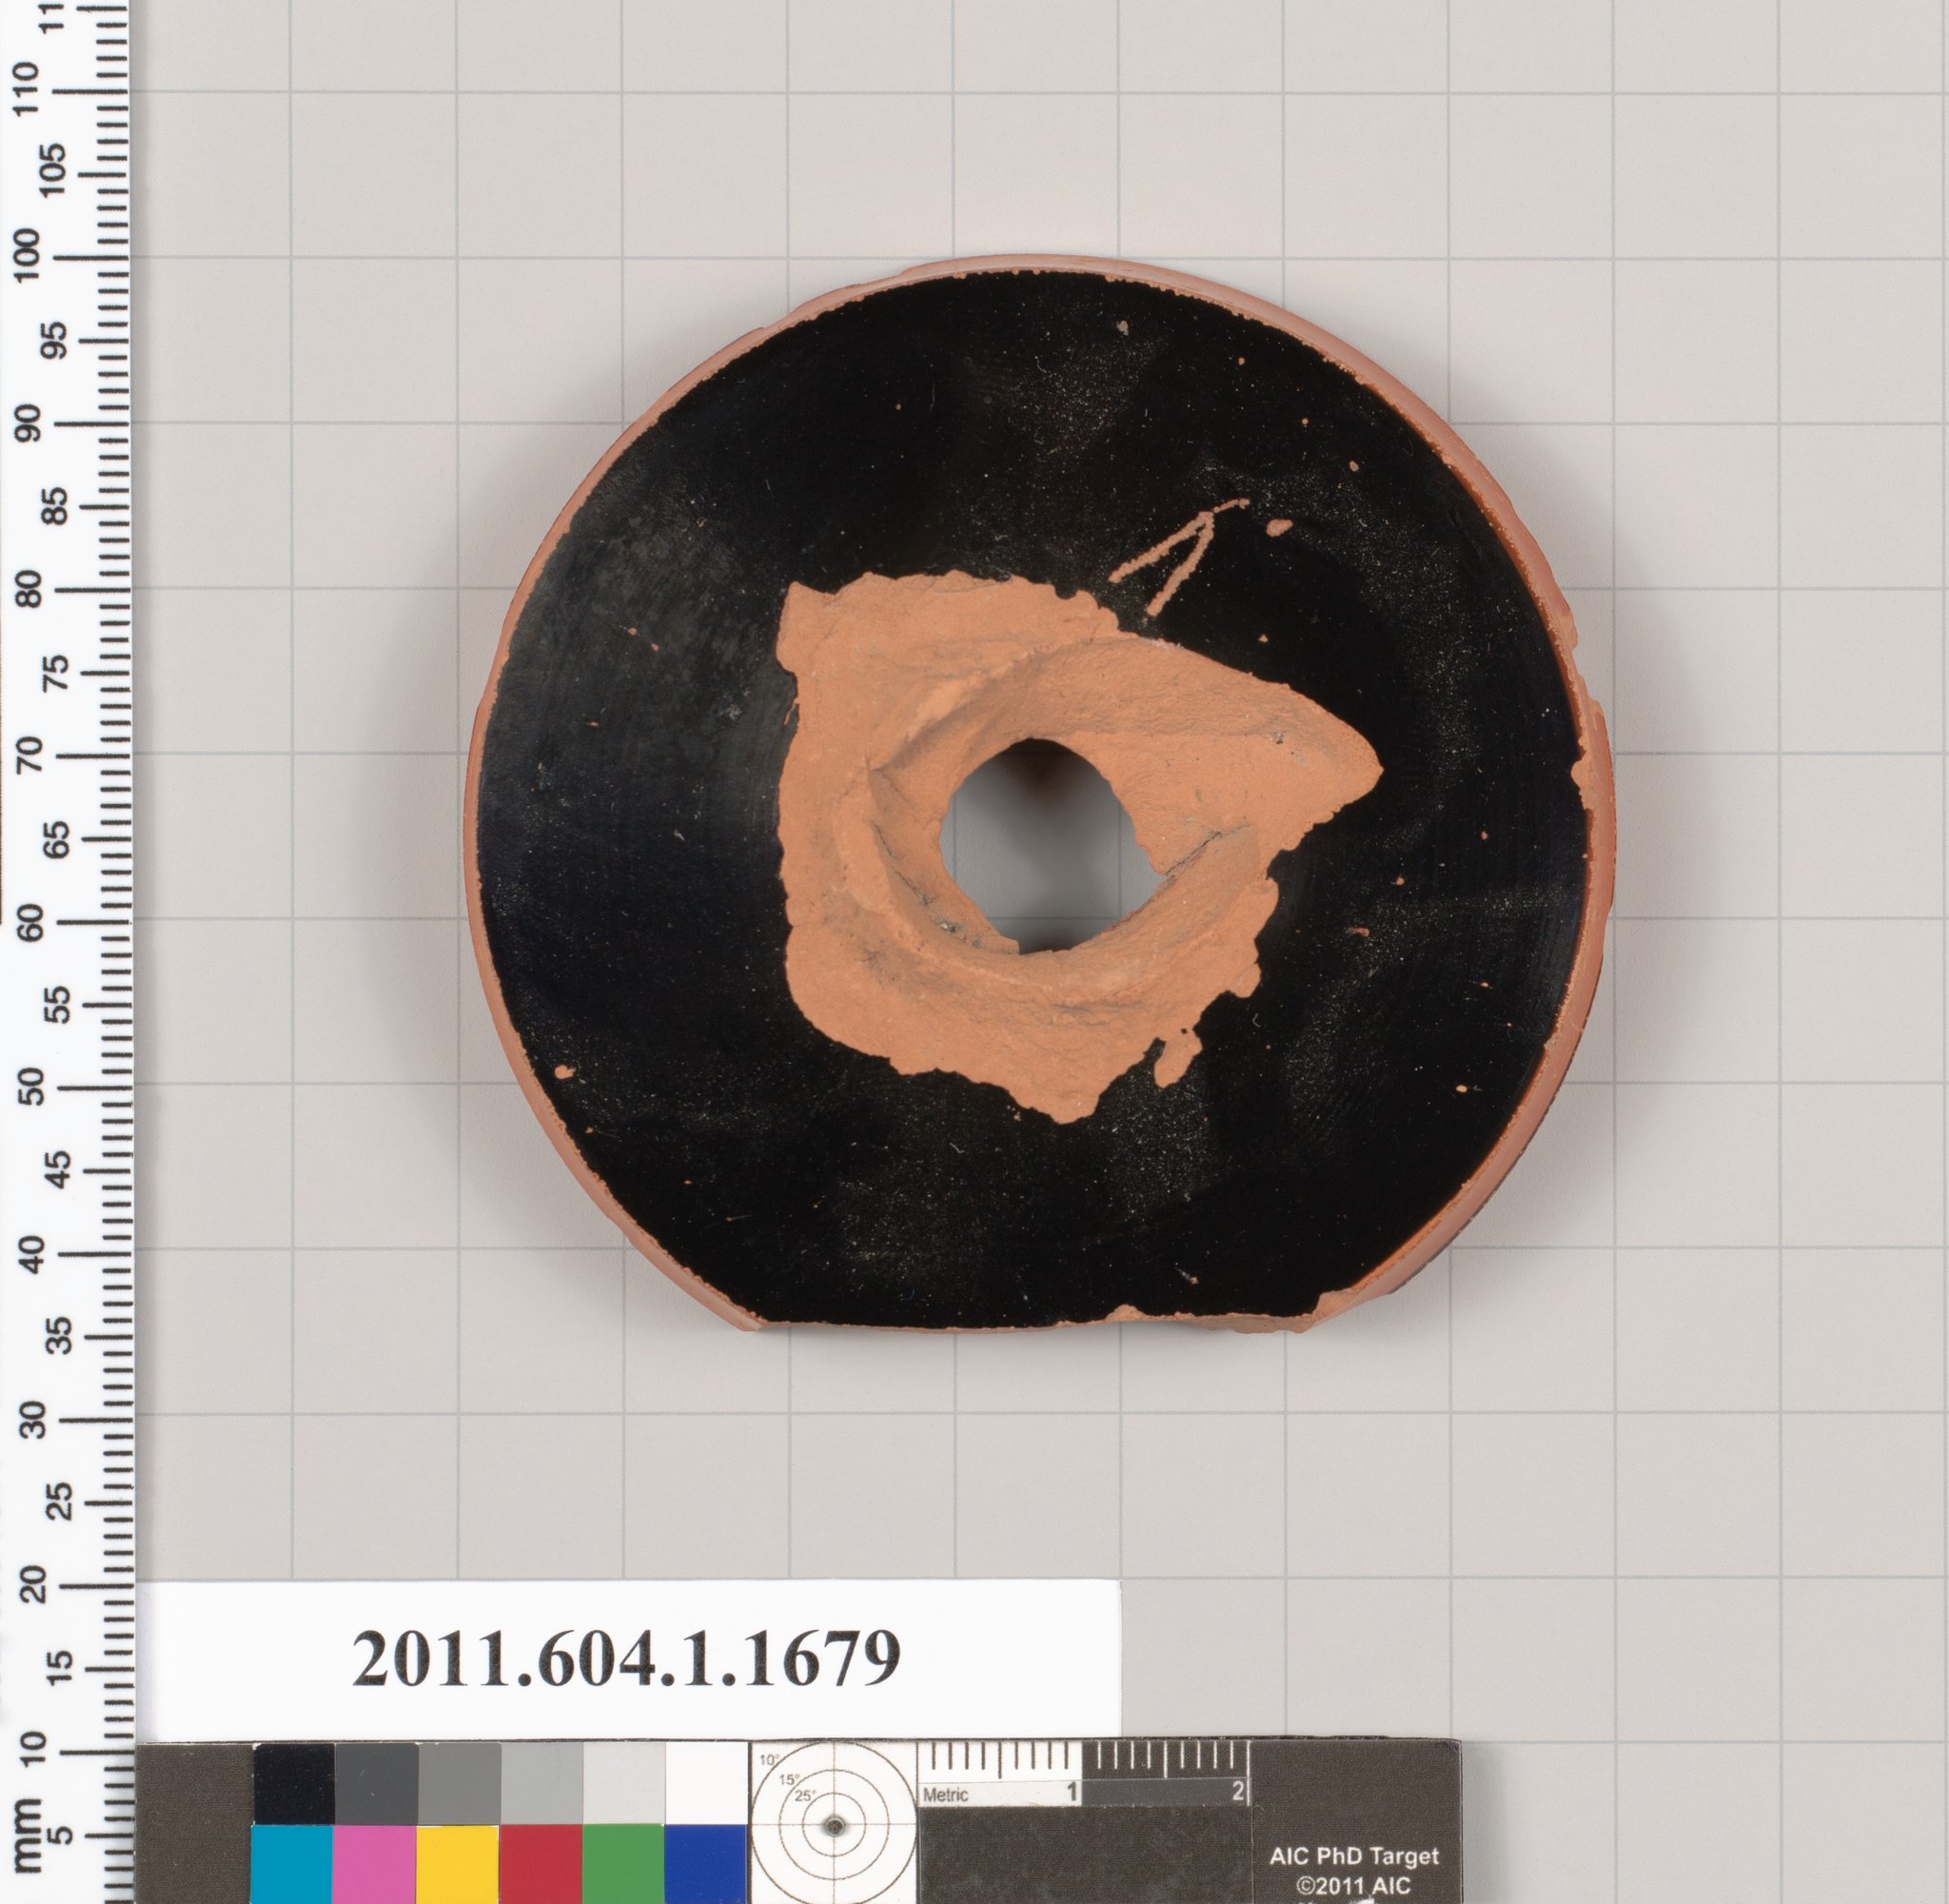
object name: kylix fragment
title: Terracotta fragment of a kylix (drinking cup)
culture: greek, attic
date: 500-401 BCE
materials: terracotta